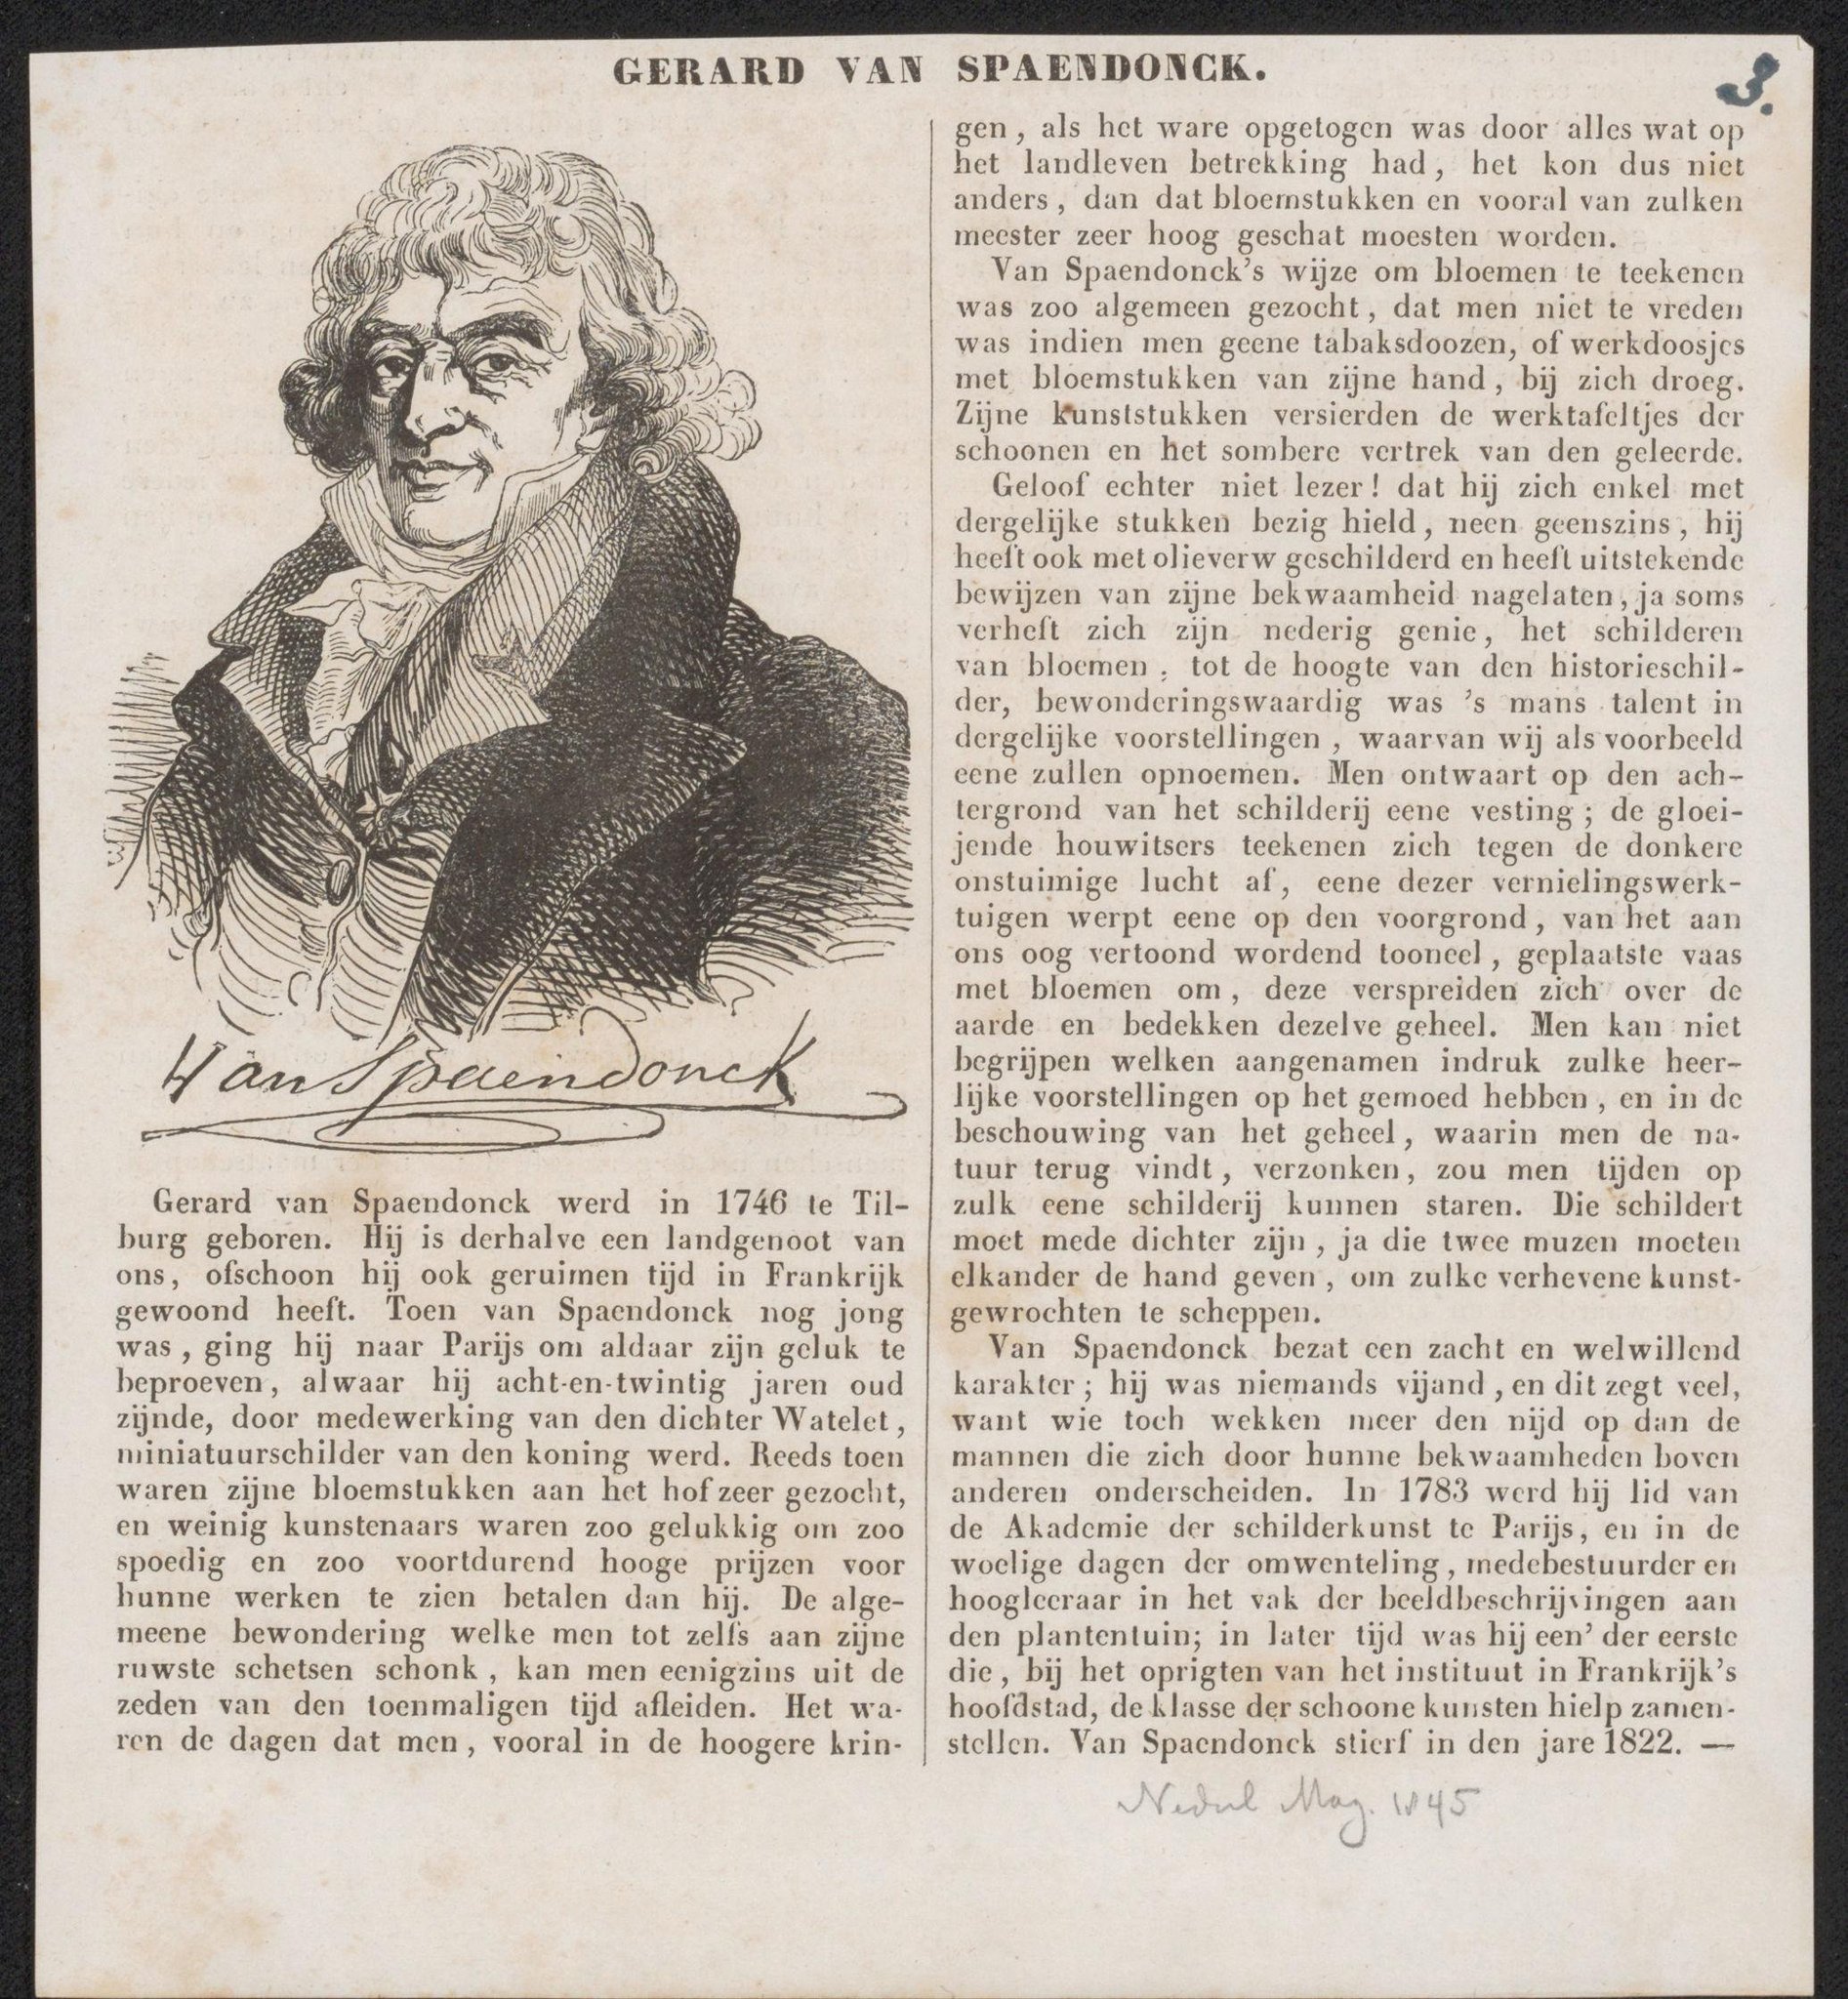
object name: document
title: Levensbericht over Gerard van Spaendonck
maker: Anonymous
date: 1845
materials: paper, pencil, ink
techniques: printing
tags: paris, print maker, draughtsman, gerard van spaendonck, historical persons (portraits and scenes from the life)